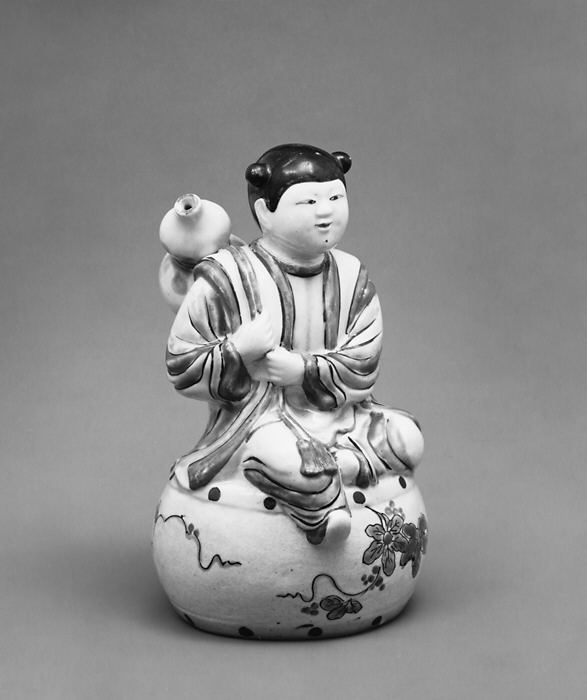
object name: water dropper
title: Water Dropper in the Shape of a Youth Seated on a Drum and Holding a Gourd on His Back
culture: japanese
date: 1601-1700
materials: enamel, porcelain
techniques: overglaze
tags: men,drums,gourds